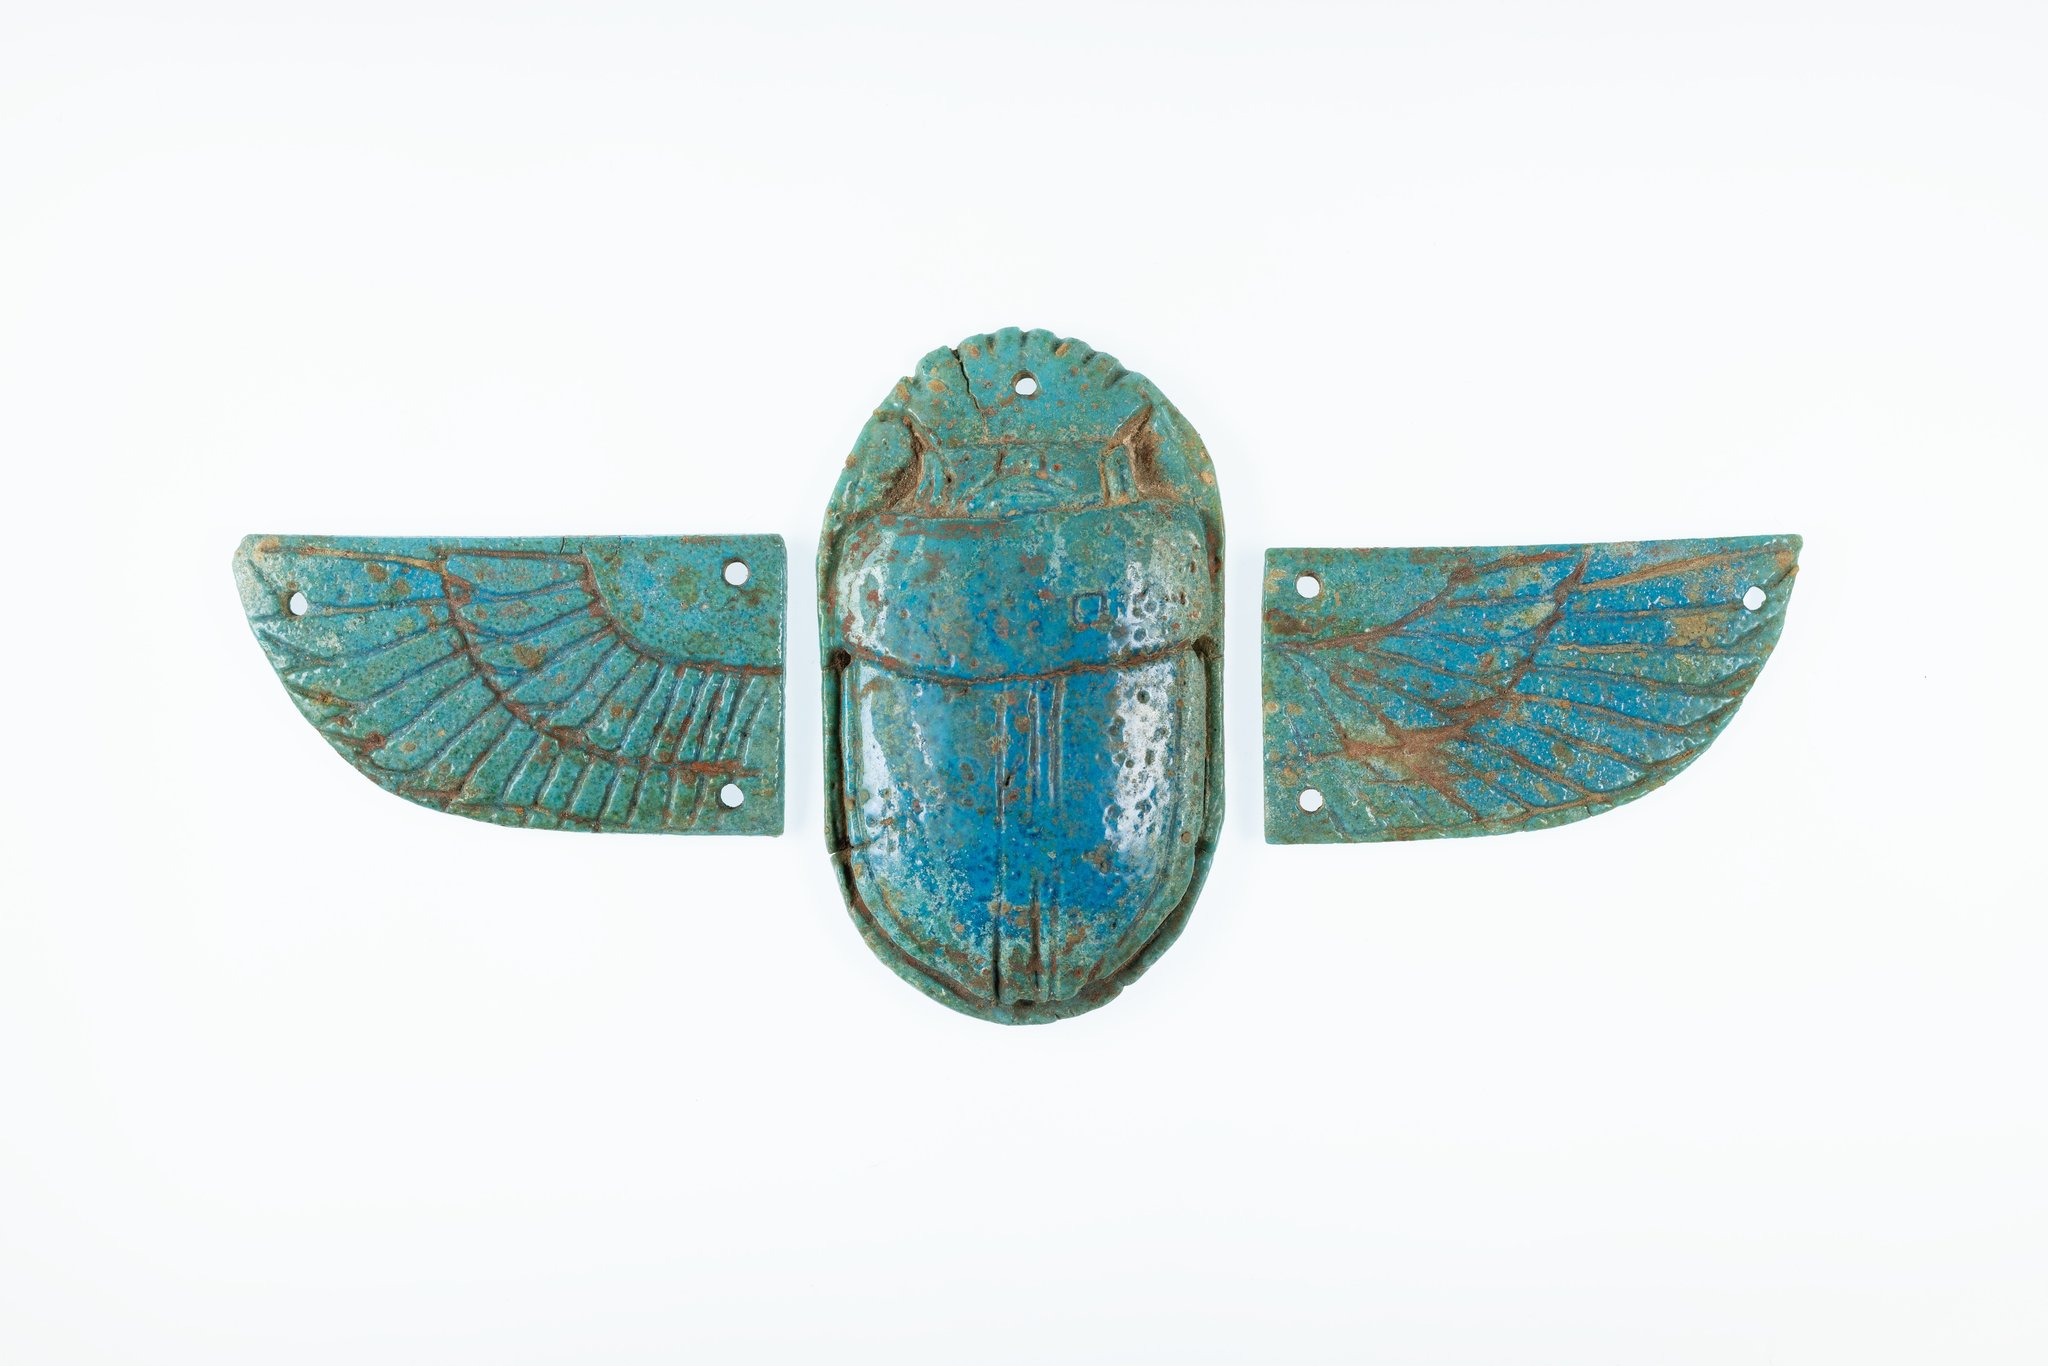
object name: amulet, winged scarab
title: Winged scarab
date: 664-630 BCE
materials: faience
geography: egypt